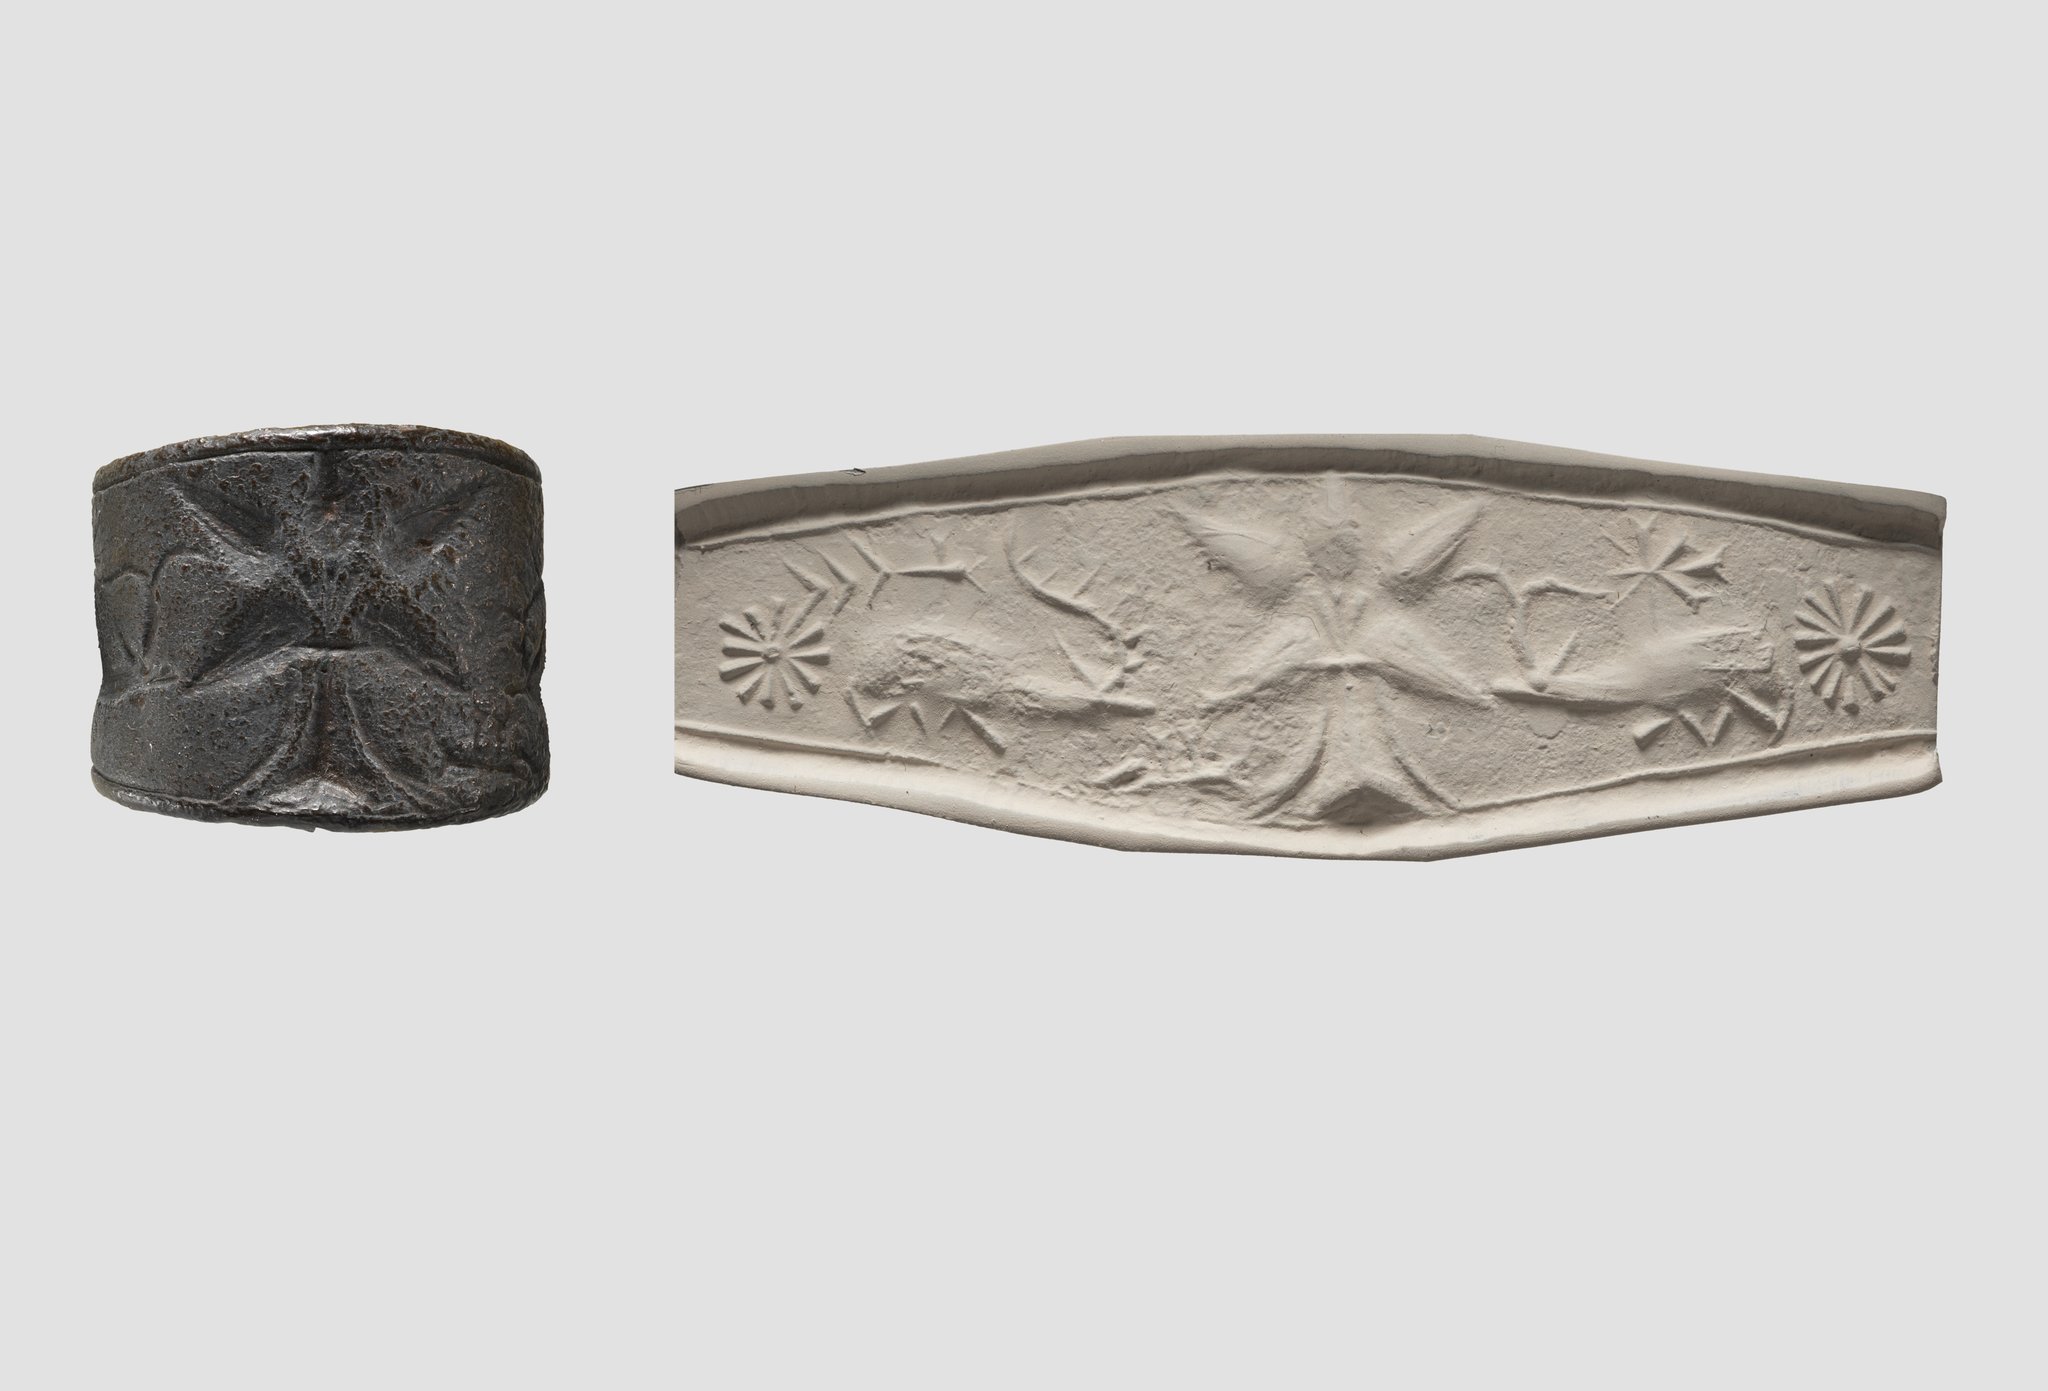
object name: stamp seal ring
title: Seal ring: horned animals flanking a tree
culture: iranian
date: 1000-701 BCE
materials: bronze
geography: iran, luristan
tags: animals